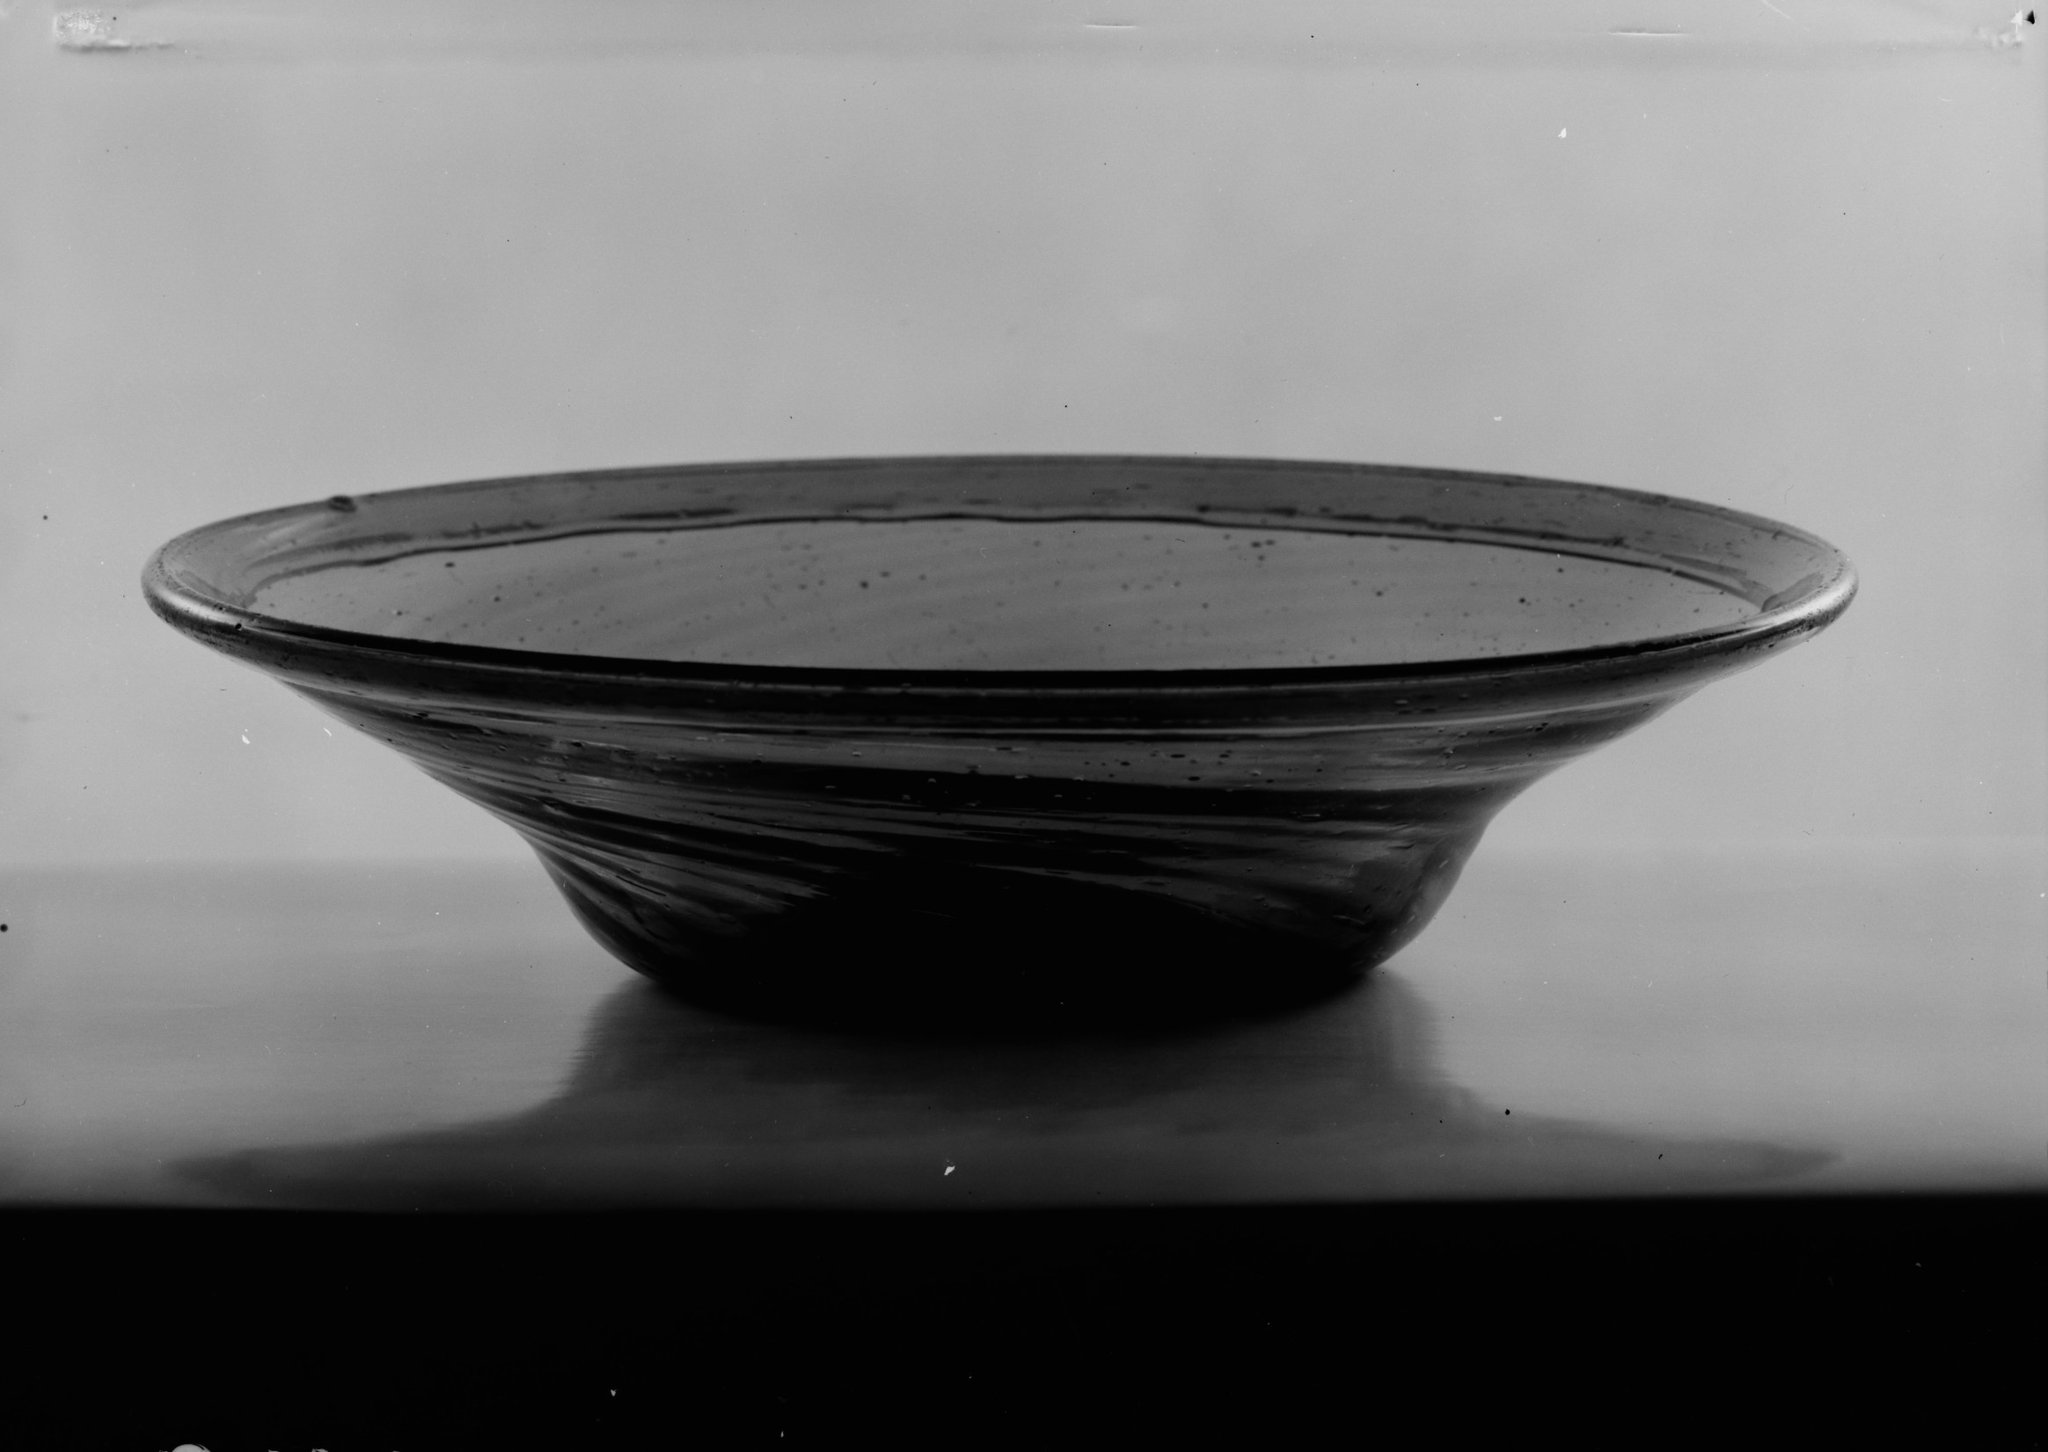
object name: bowl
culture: american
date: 1800-1830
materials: glass, lead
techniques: glassblowing, molding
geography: united states